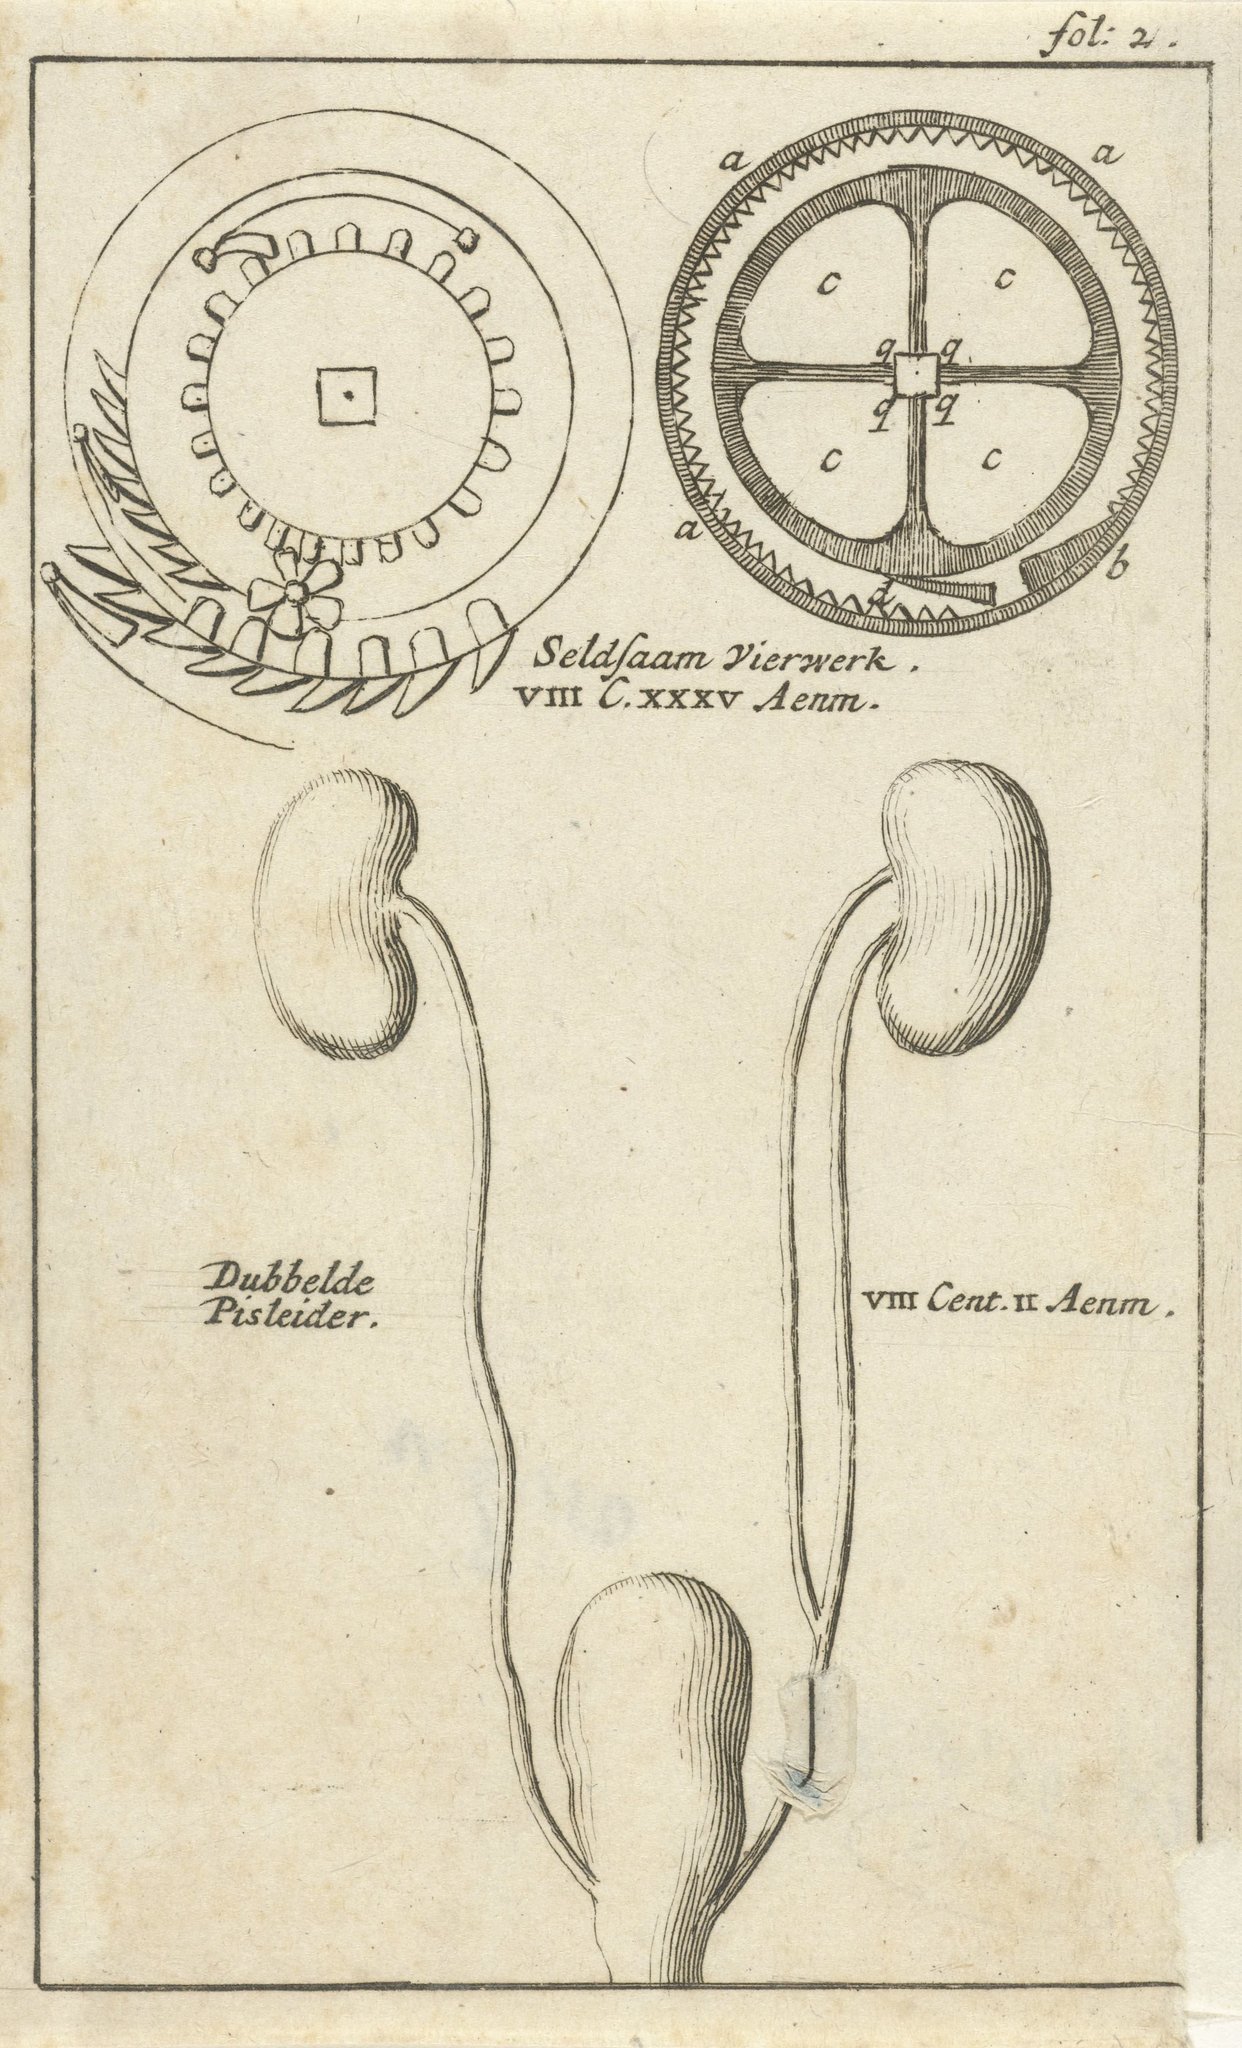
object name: book illustration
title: Anatomische afbeelding XXI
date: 1680-1688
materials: paper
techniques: etching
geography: amsterdam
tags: biology, anatomical models (usually series of five figures)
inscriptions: collector's mark: Lugt 2228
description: Illustratie opgenomen in: Blankaart, Steven. Collectanea medico-physica, oft Hollands jaar-register der genees- en natuur-kundige aanmerkingen, 3 delen, dl. III, fol. 2. Amsterdam: Jan Claesz ten Hoorn, 1680-1688.